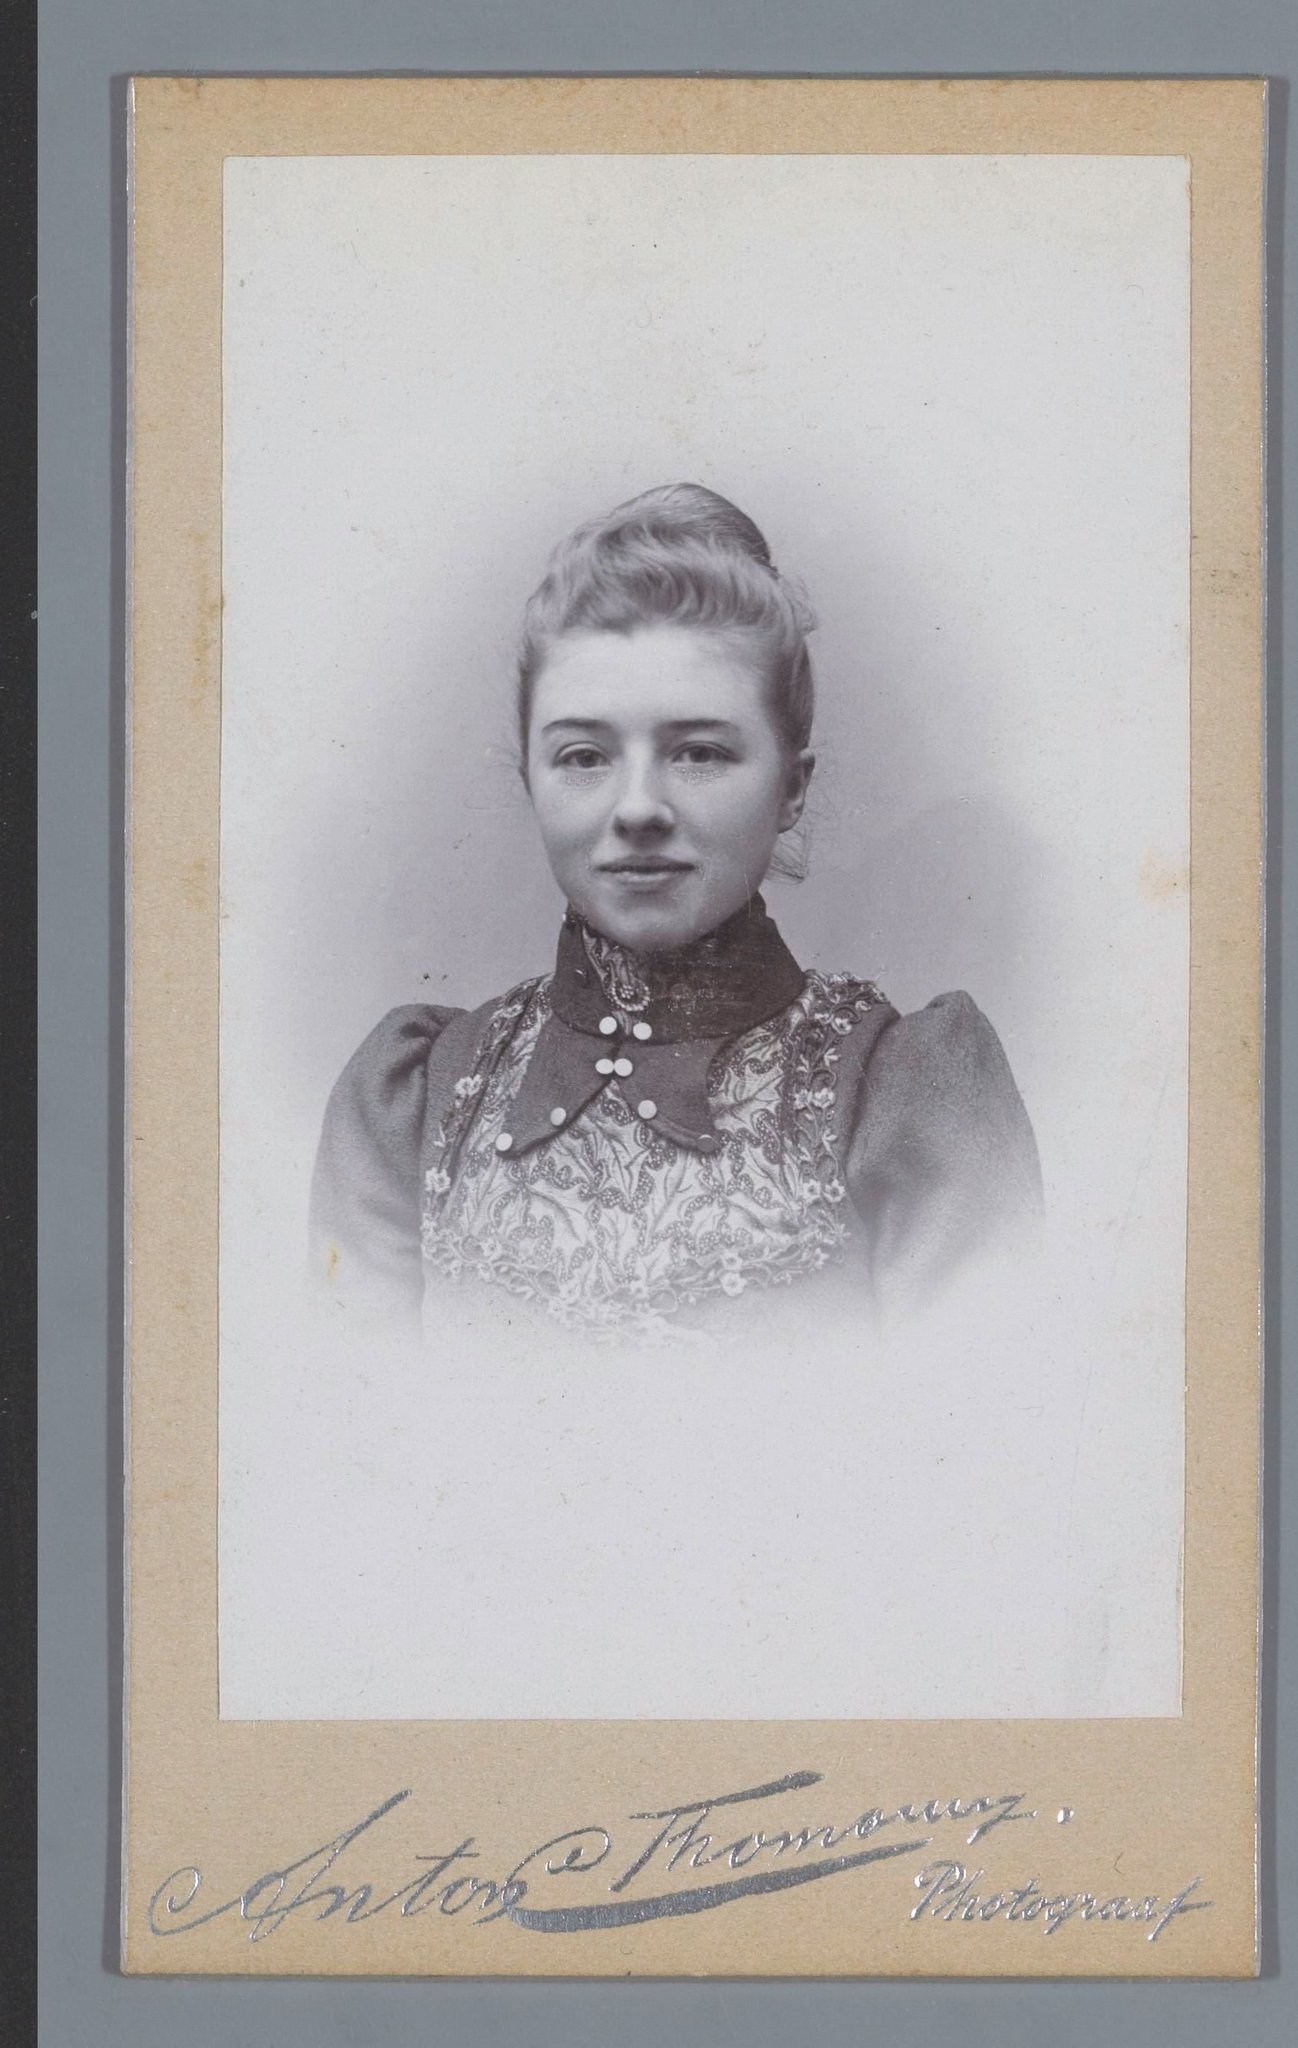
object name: carte de visite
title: Portret van een onbekende vrouw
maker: anton cornelis thomann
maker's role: fotograaf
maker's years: 1873-1946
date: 1894-1909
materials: cardboard, paper, photographic support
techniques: collodion silver print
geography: utrecht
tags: adult woman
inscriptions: name: ‘Anton C Thomann Photograaf’, name: ‘A.C. Thomann Phot. intercommunaal telefoon nummer 893 Utrecht Witte vrouwe singel 91,5e huis van af de gasfabr. (...)’